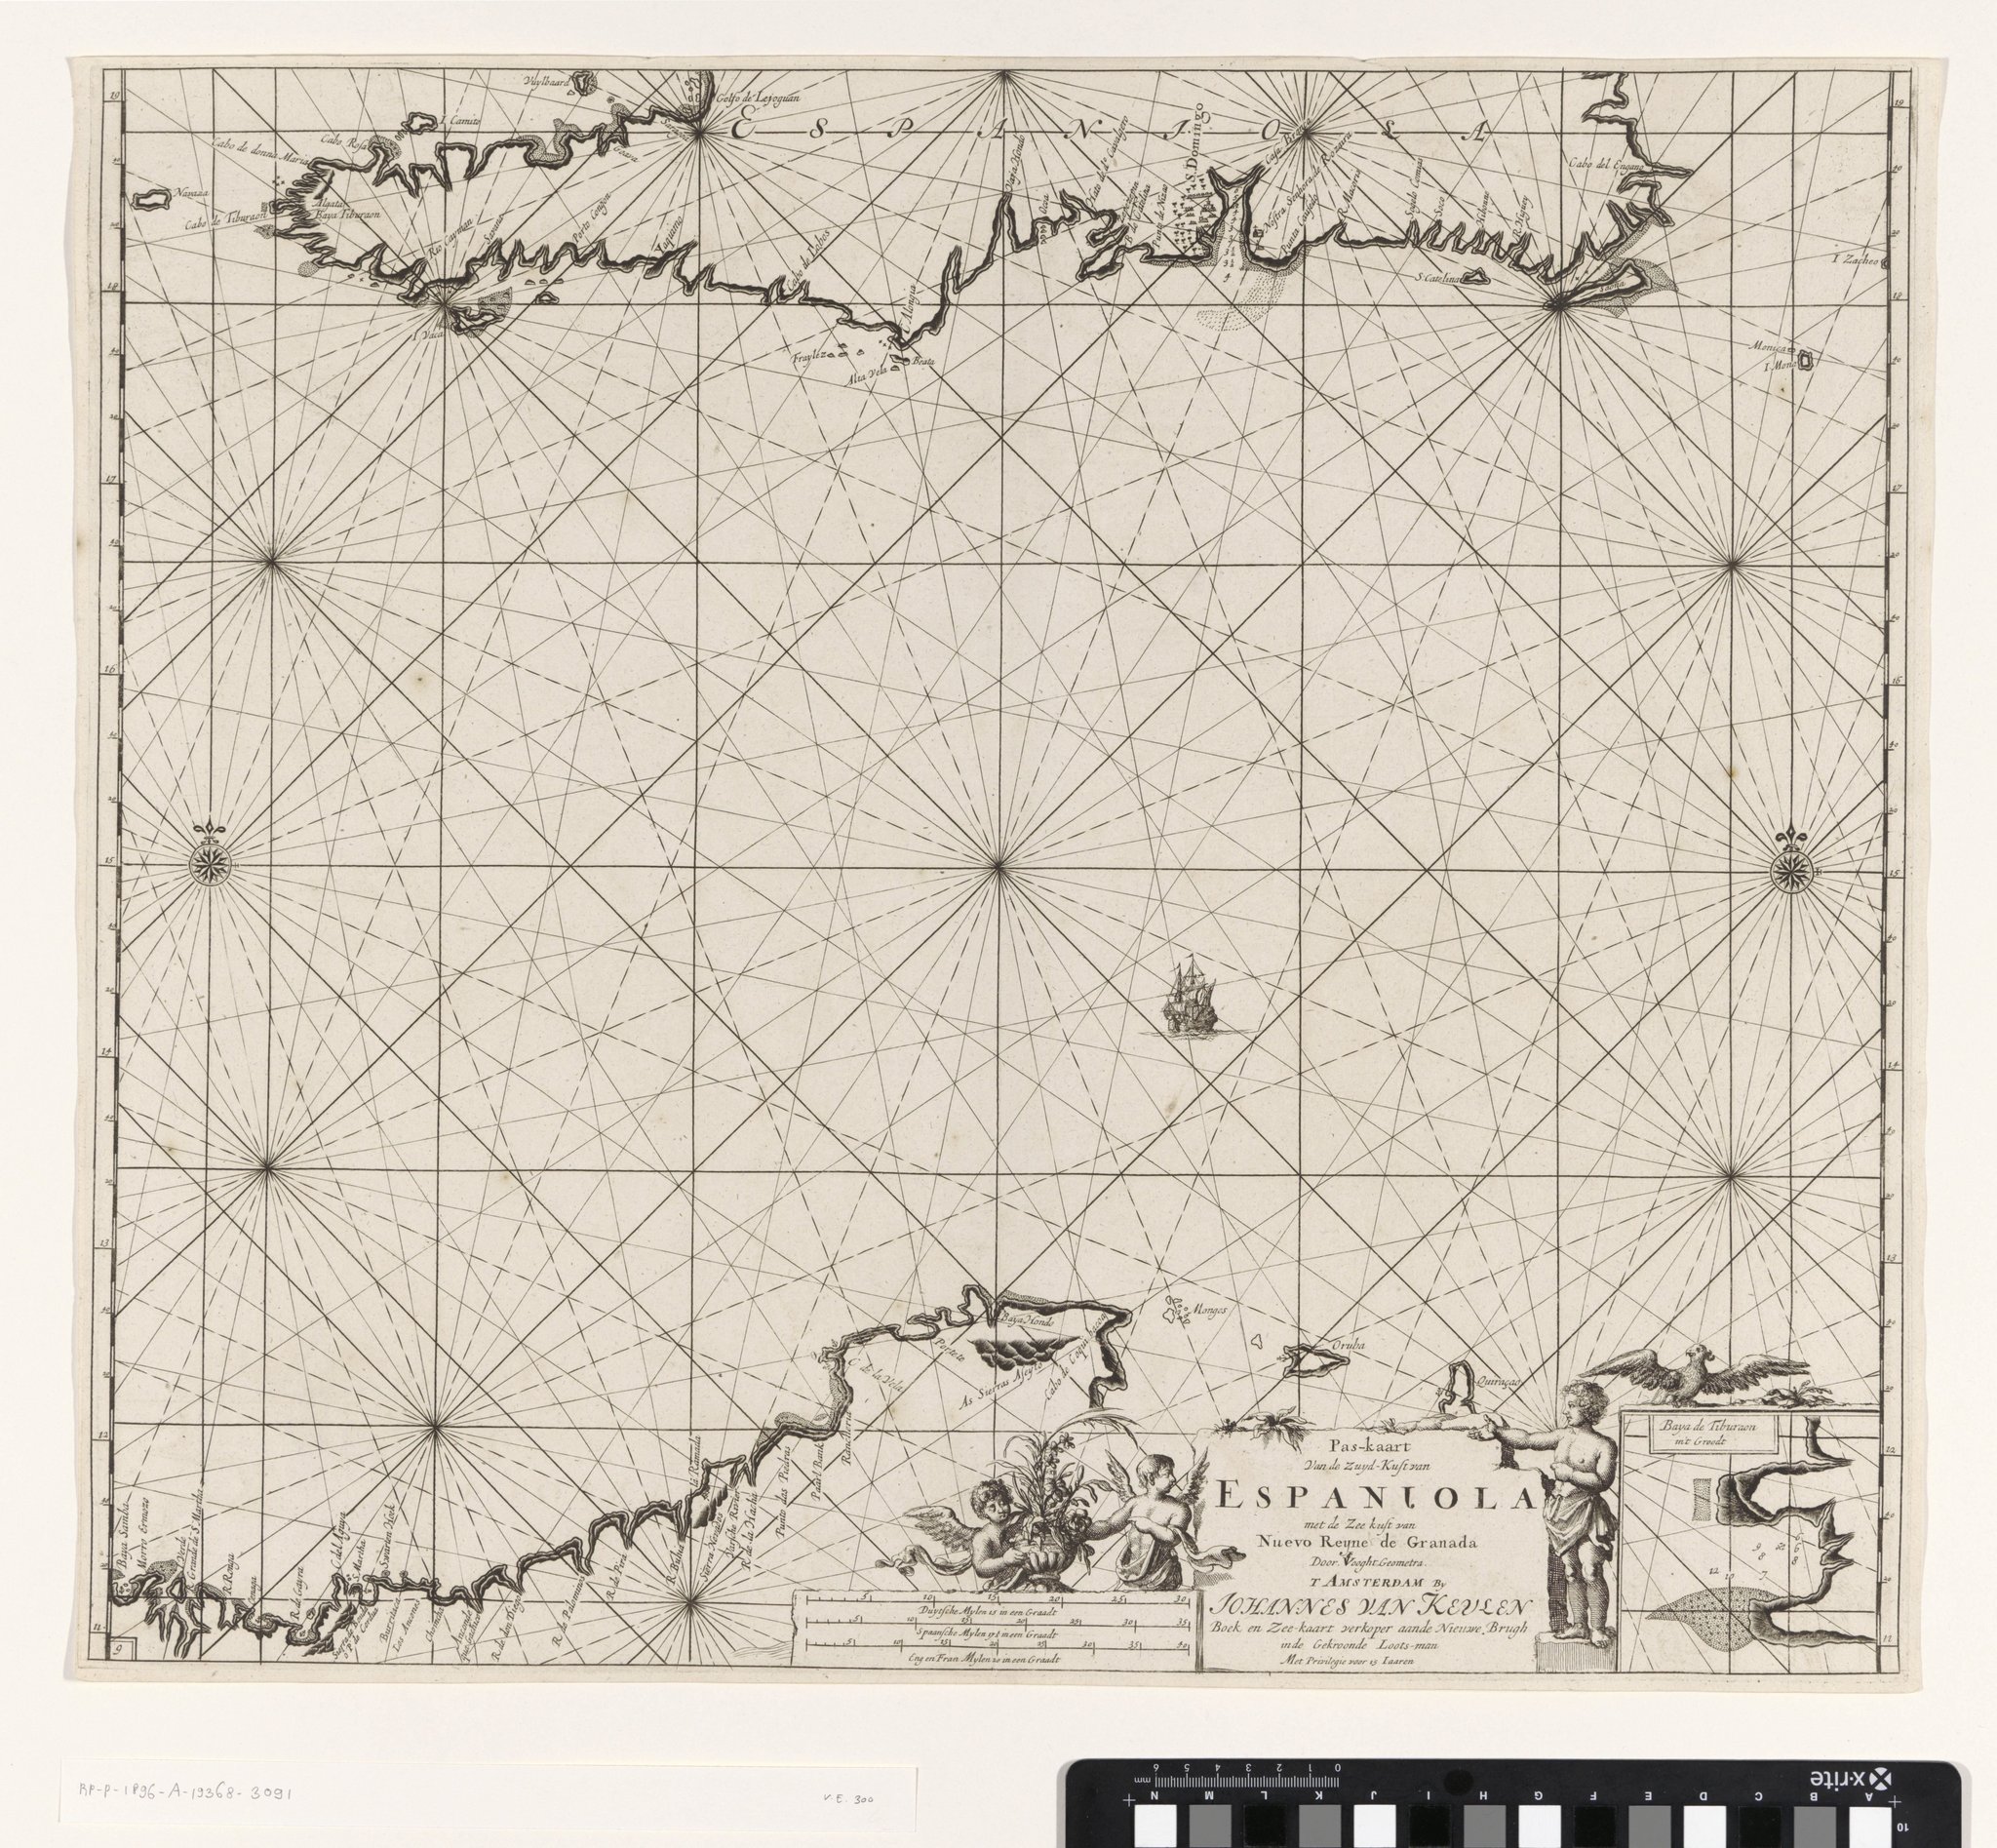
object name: print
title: Paskaart van Haïti, de Dominicaanse Republiek, Venezuela en Curaçao en Aruba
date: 1684-1799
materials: paper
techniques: engraving, etching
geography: amsterdam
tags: flowers, sailing-ship, sailing-boat, birds, cupids: 'amores', 'amoretti', 'putti'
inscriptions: collector's mark: Lugt 2228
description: Paskaart van de zuidkust van Haïti, de zuidkust van de Dominicaanse Republiek, Curaçao, Aruba en een deel van de noordkust van Venezuela. Rechtsonder een inzet met een kaart van een haven. Middenonder de titel, het adres van de uitgever en de schaalverdeling, weergegeven in Duitse, Spaanse en Engelse of Franse mijlen. De gegevens zijn versierd met een jongen een twee engeltjes met bloemen.